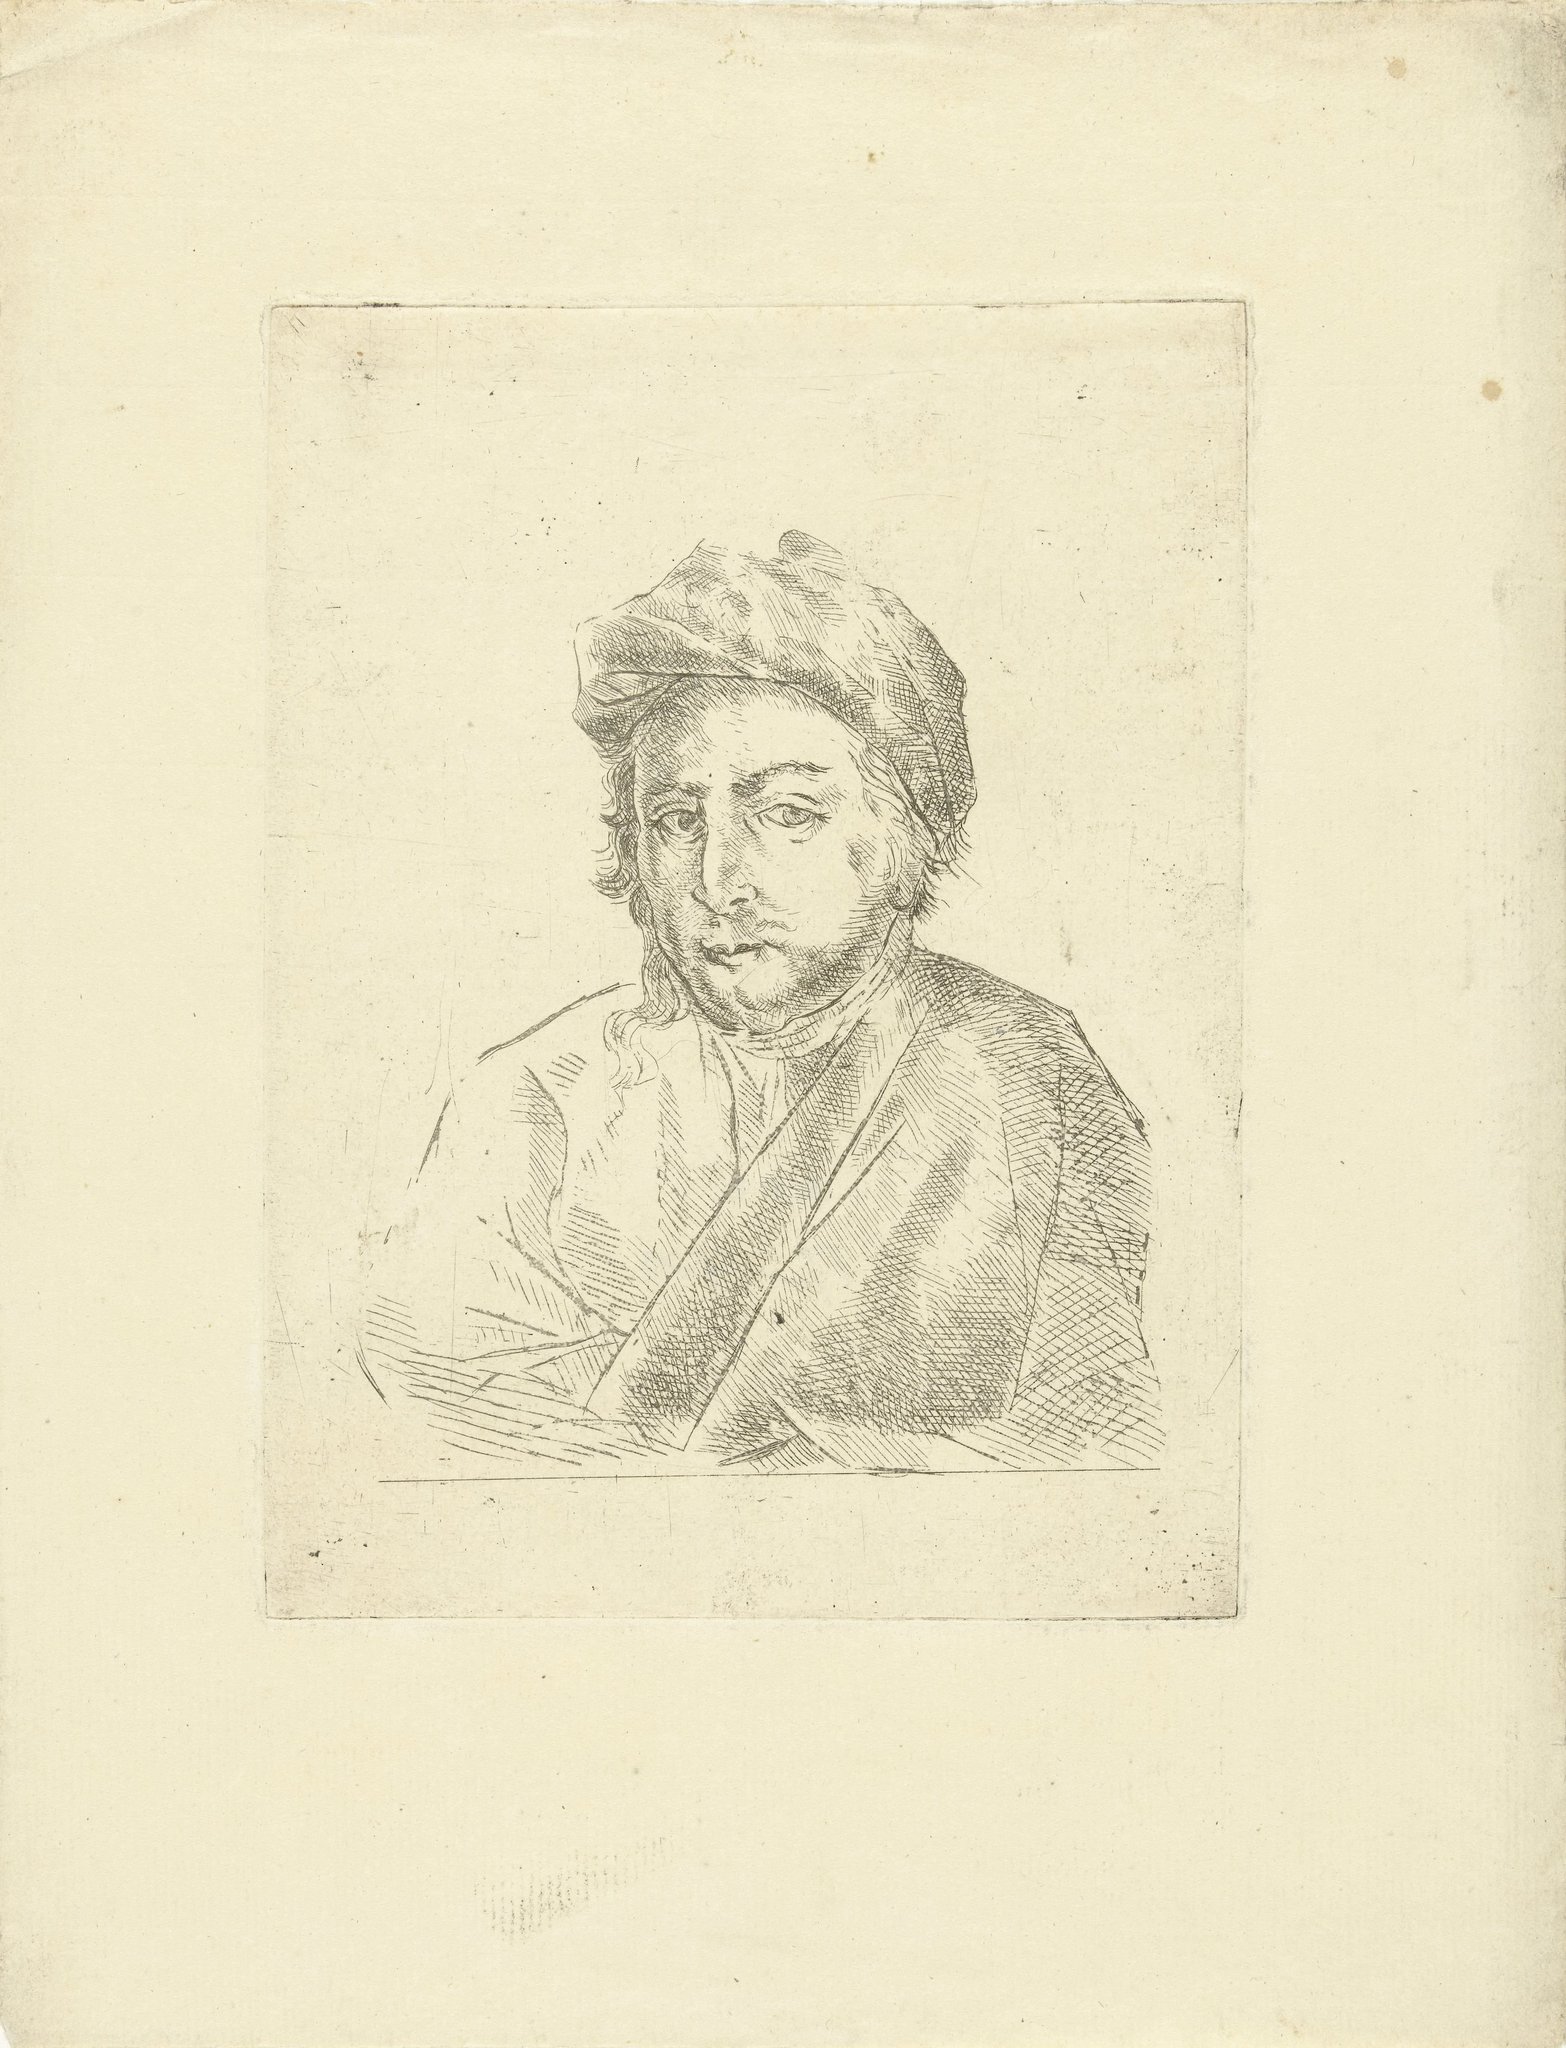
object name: print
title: Portret van een man met doek op zijn hoofd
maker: g. van citters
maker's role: print maker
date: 1750-1800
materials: paper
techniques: drypoint, etching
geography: netherlands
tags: anonymous historical person portrayed alone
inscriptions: collector's mark: Lugt 2233